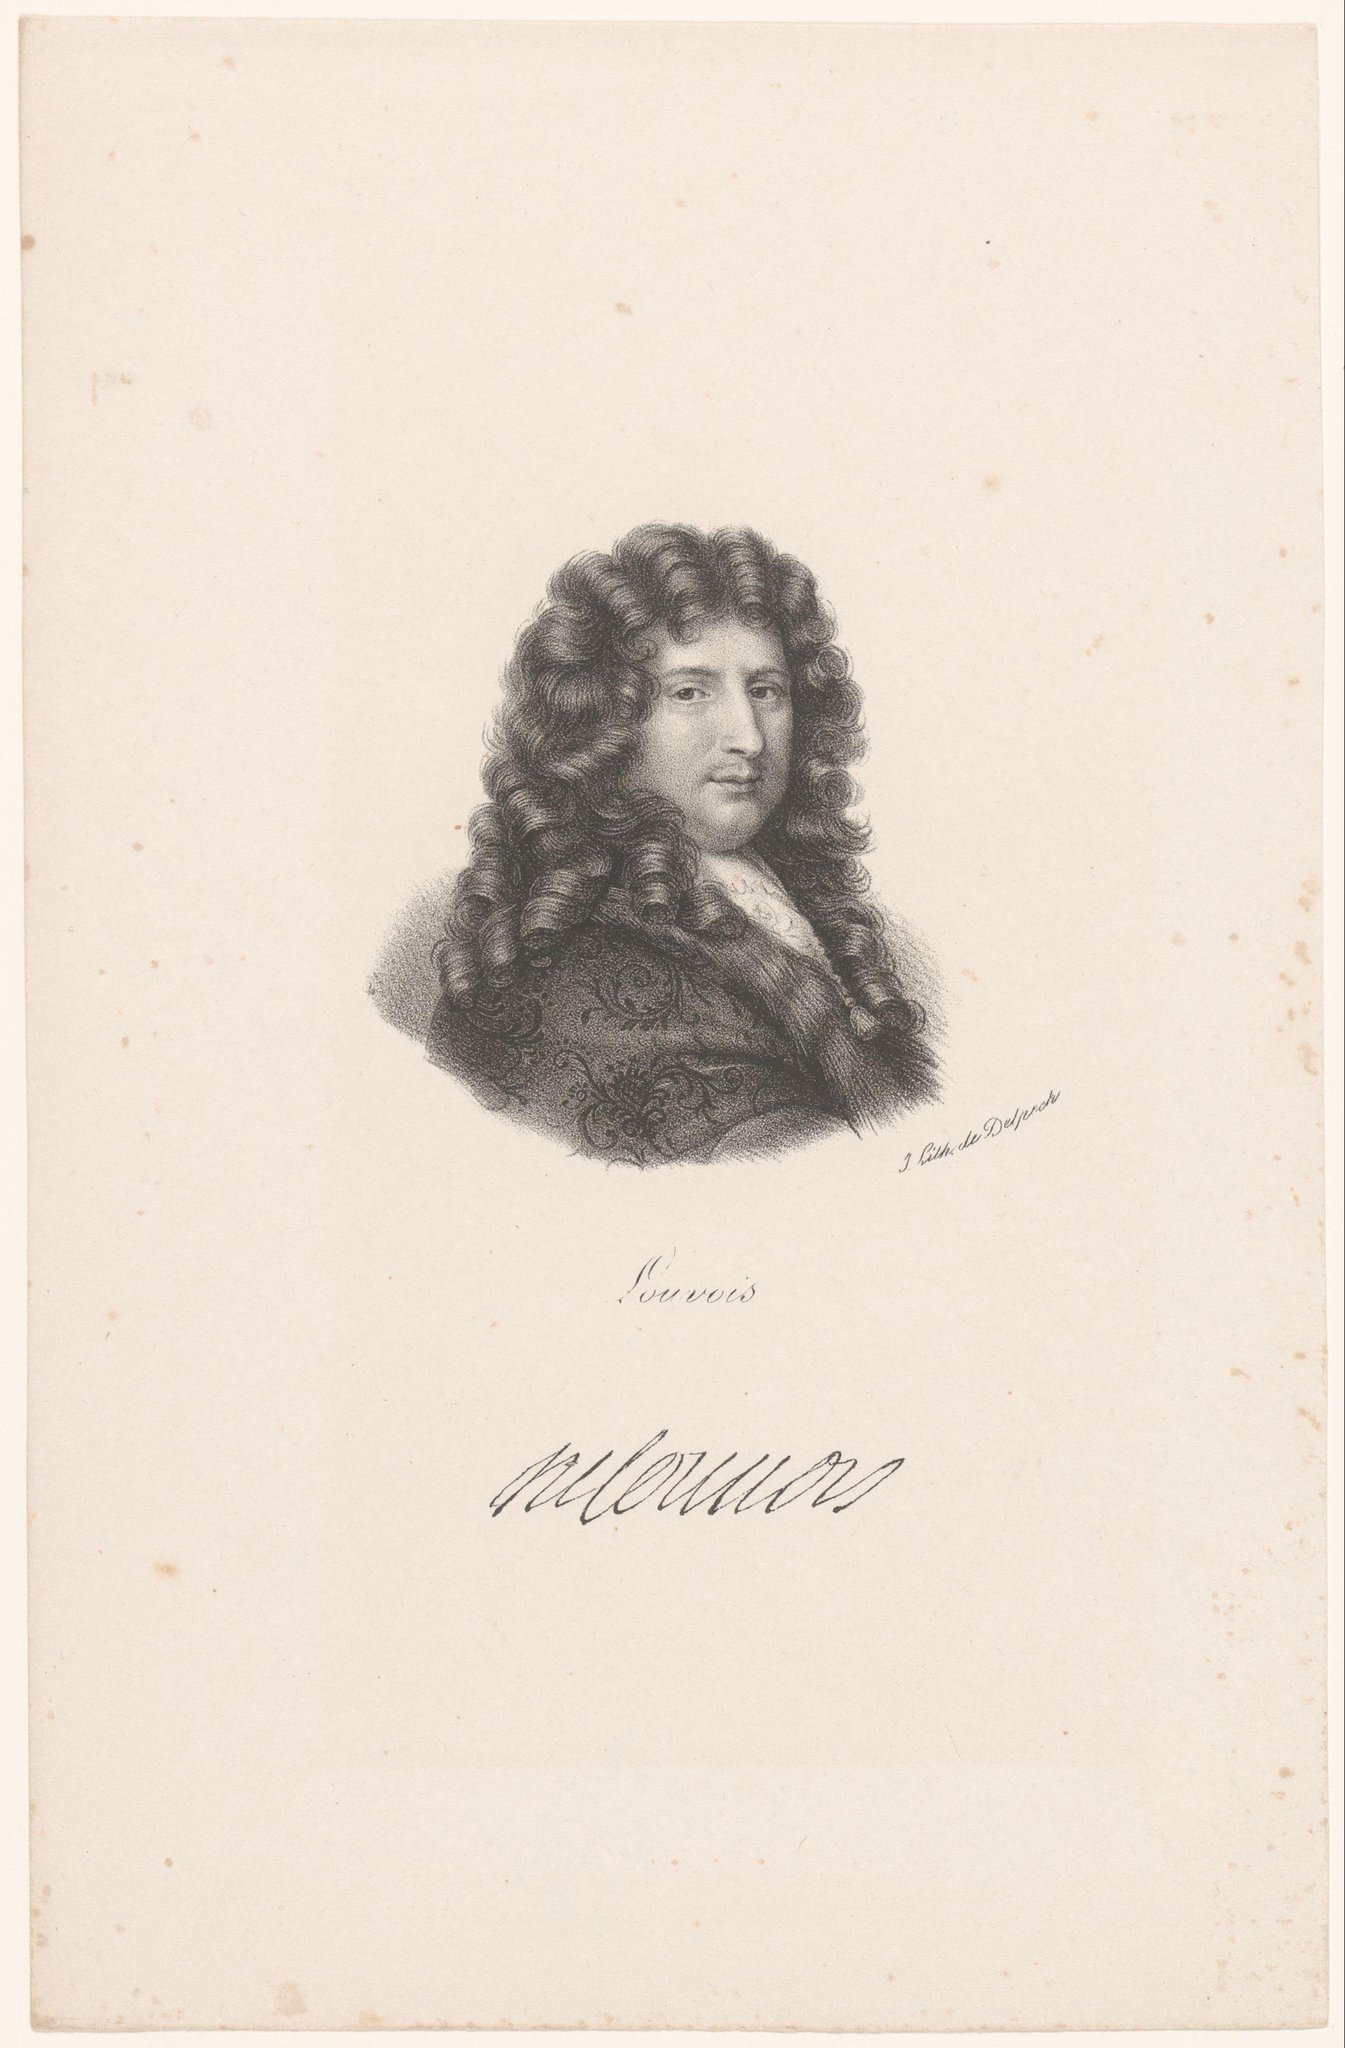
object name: print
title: Louvois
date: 1818-1842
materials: paper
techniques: lithograph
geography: paris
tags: paris, françois-michel le tellier (markies de louvois), historical persons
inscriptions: collector's mark: Lugt 2228a